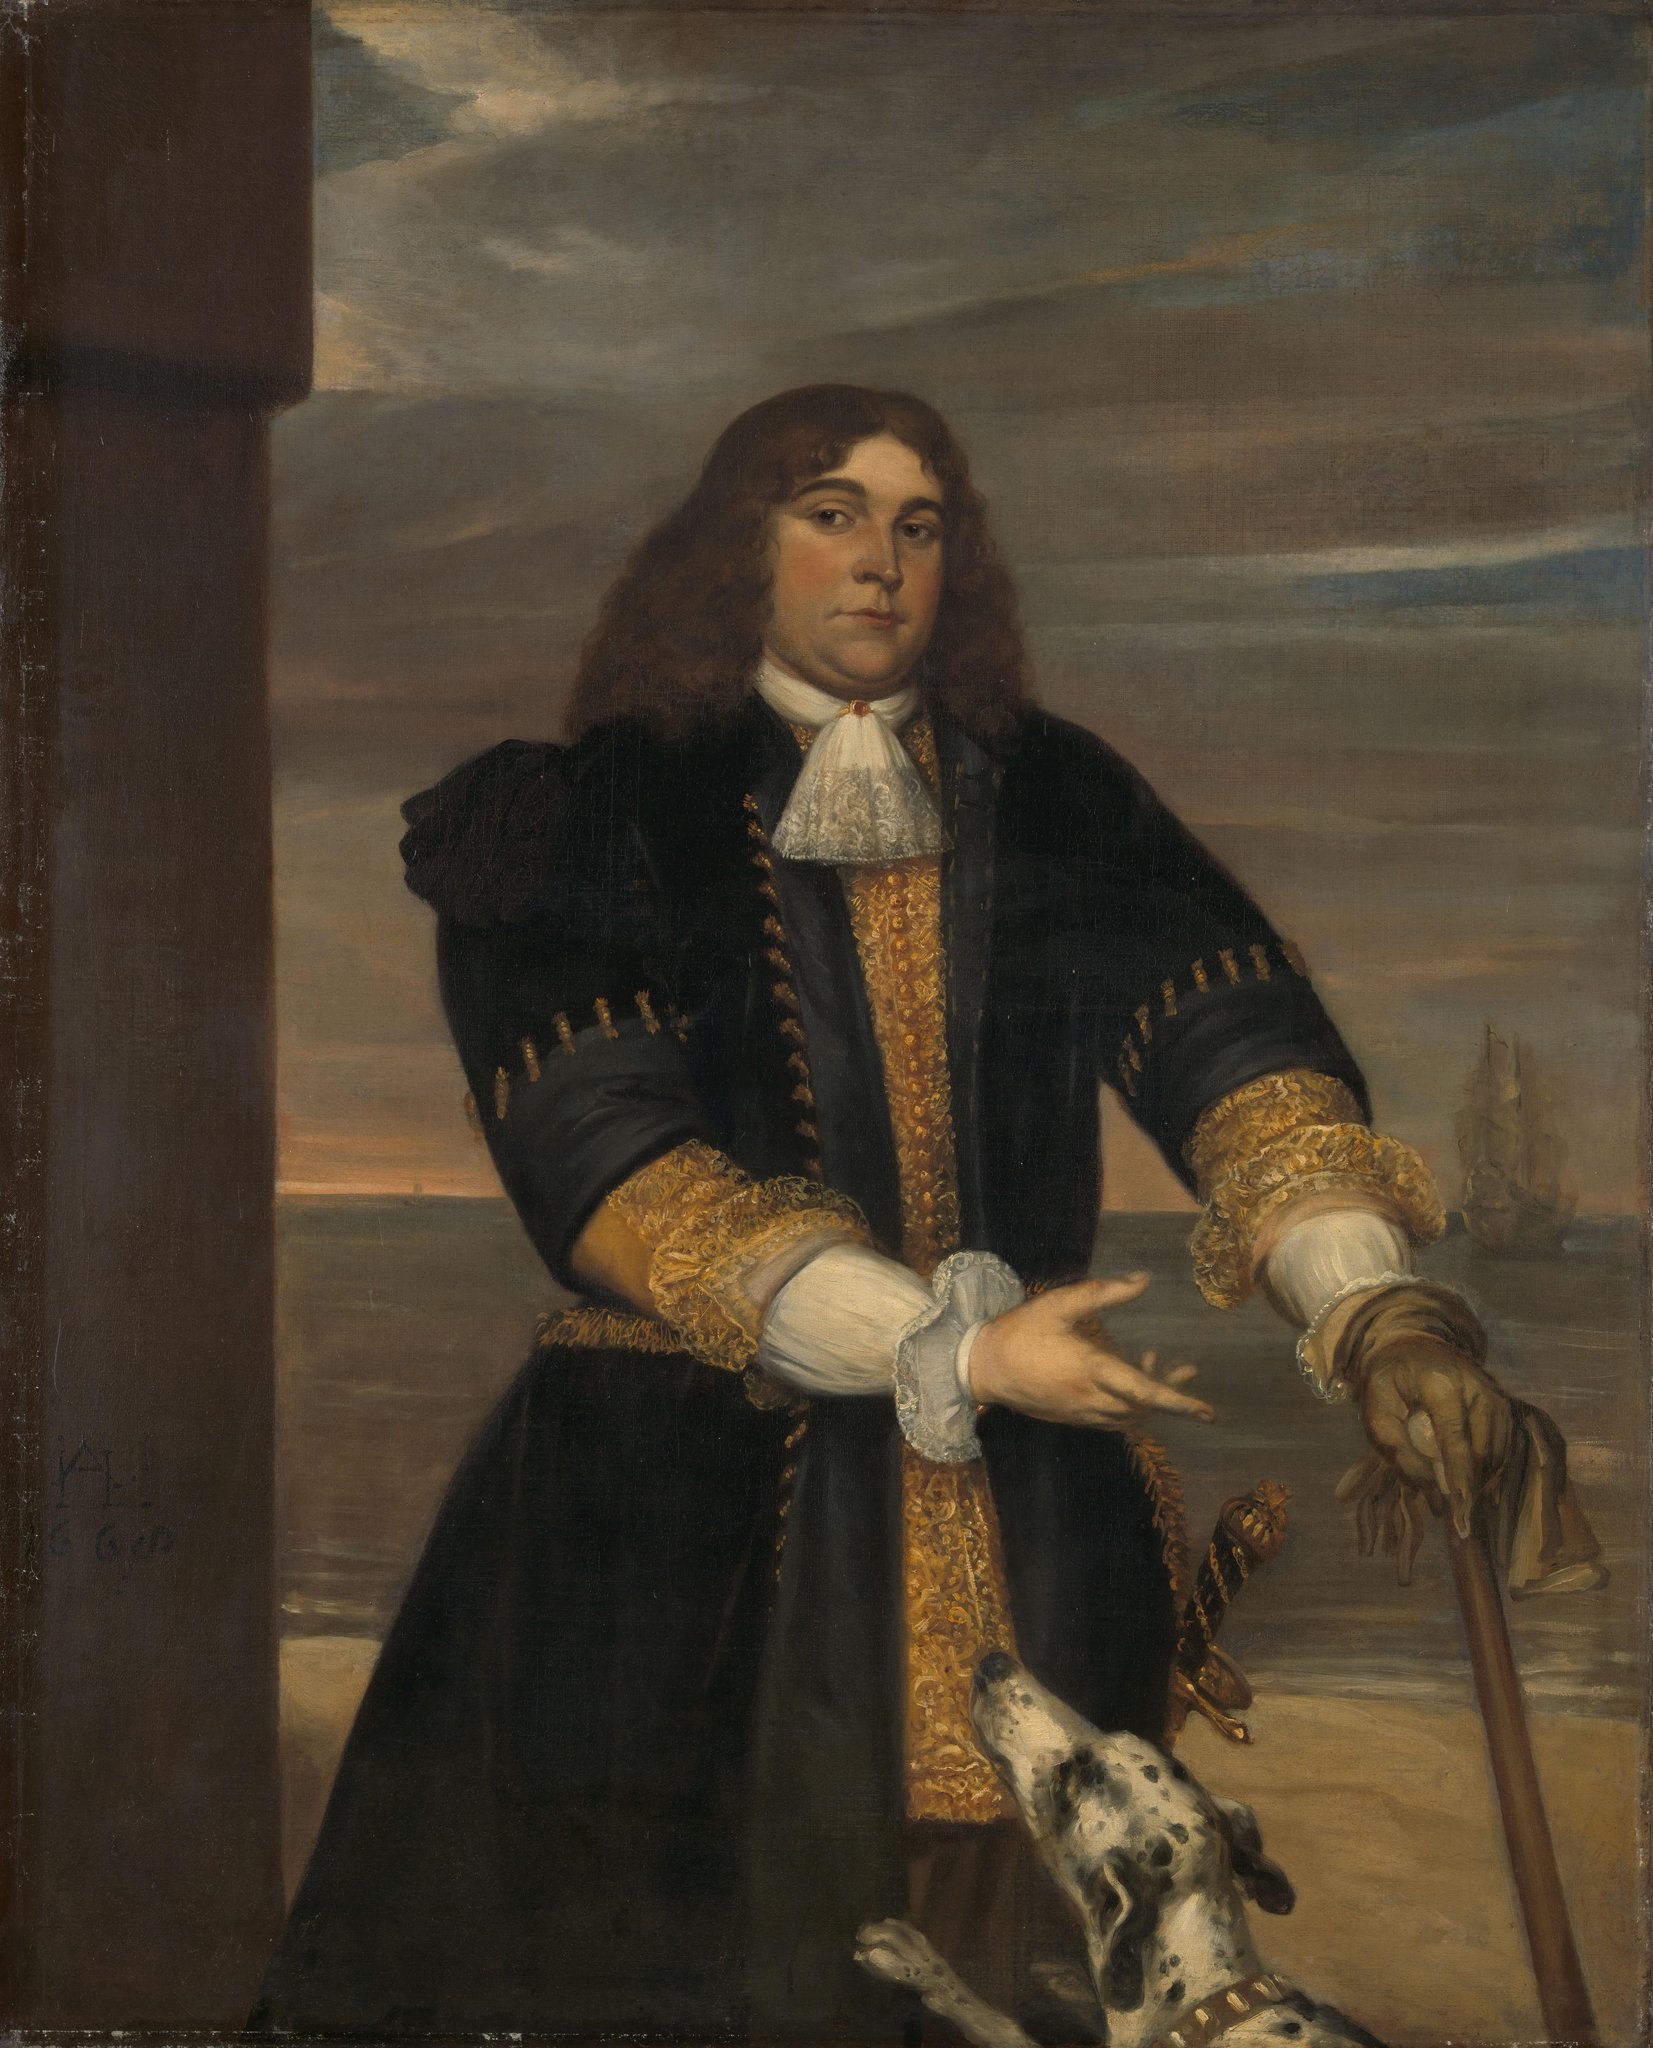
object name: painting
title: Jan van Gelder (1647-73), Naval Captain, Stepson of Michiel Adriaensz de Ruyter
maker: jan andrea lievens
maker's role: painter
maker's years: 1644-1680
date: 1668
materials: canvas, oil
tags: historical persons, officer, dog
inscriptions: signature and date: ‘IAL. 1668’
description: Portret van Jan van Gelder, kapitein ter zee, stiefzoon van Michiel Adriaensz de Ruyter. Kniestuk, staand voor een kust met in de verte een schip op zee. Wandelstok en handschoen in de linkerhand, gebarend met de rechterhand. Een hond springt tegen hem op.